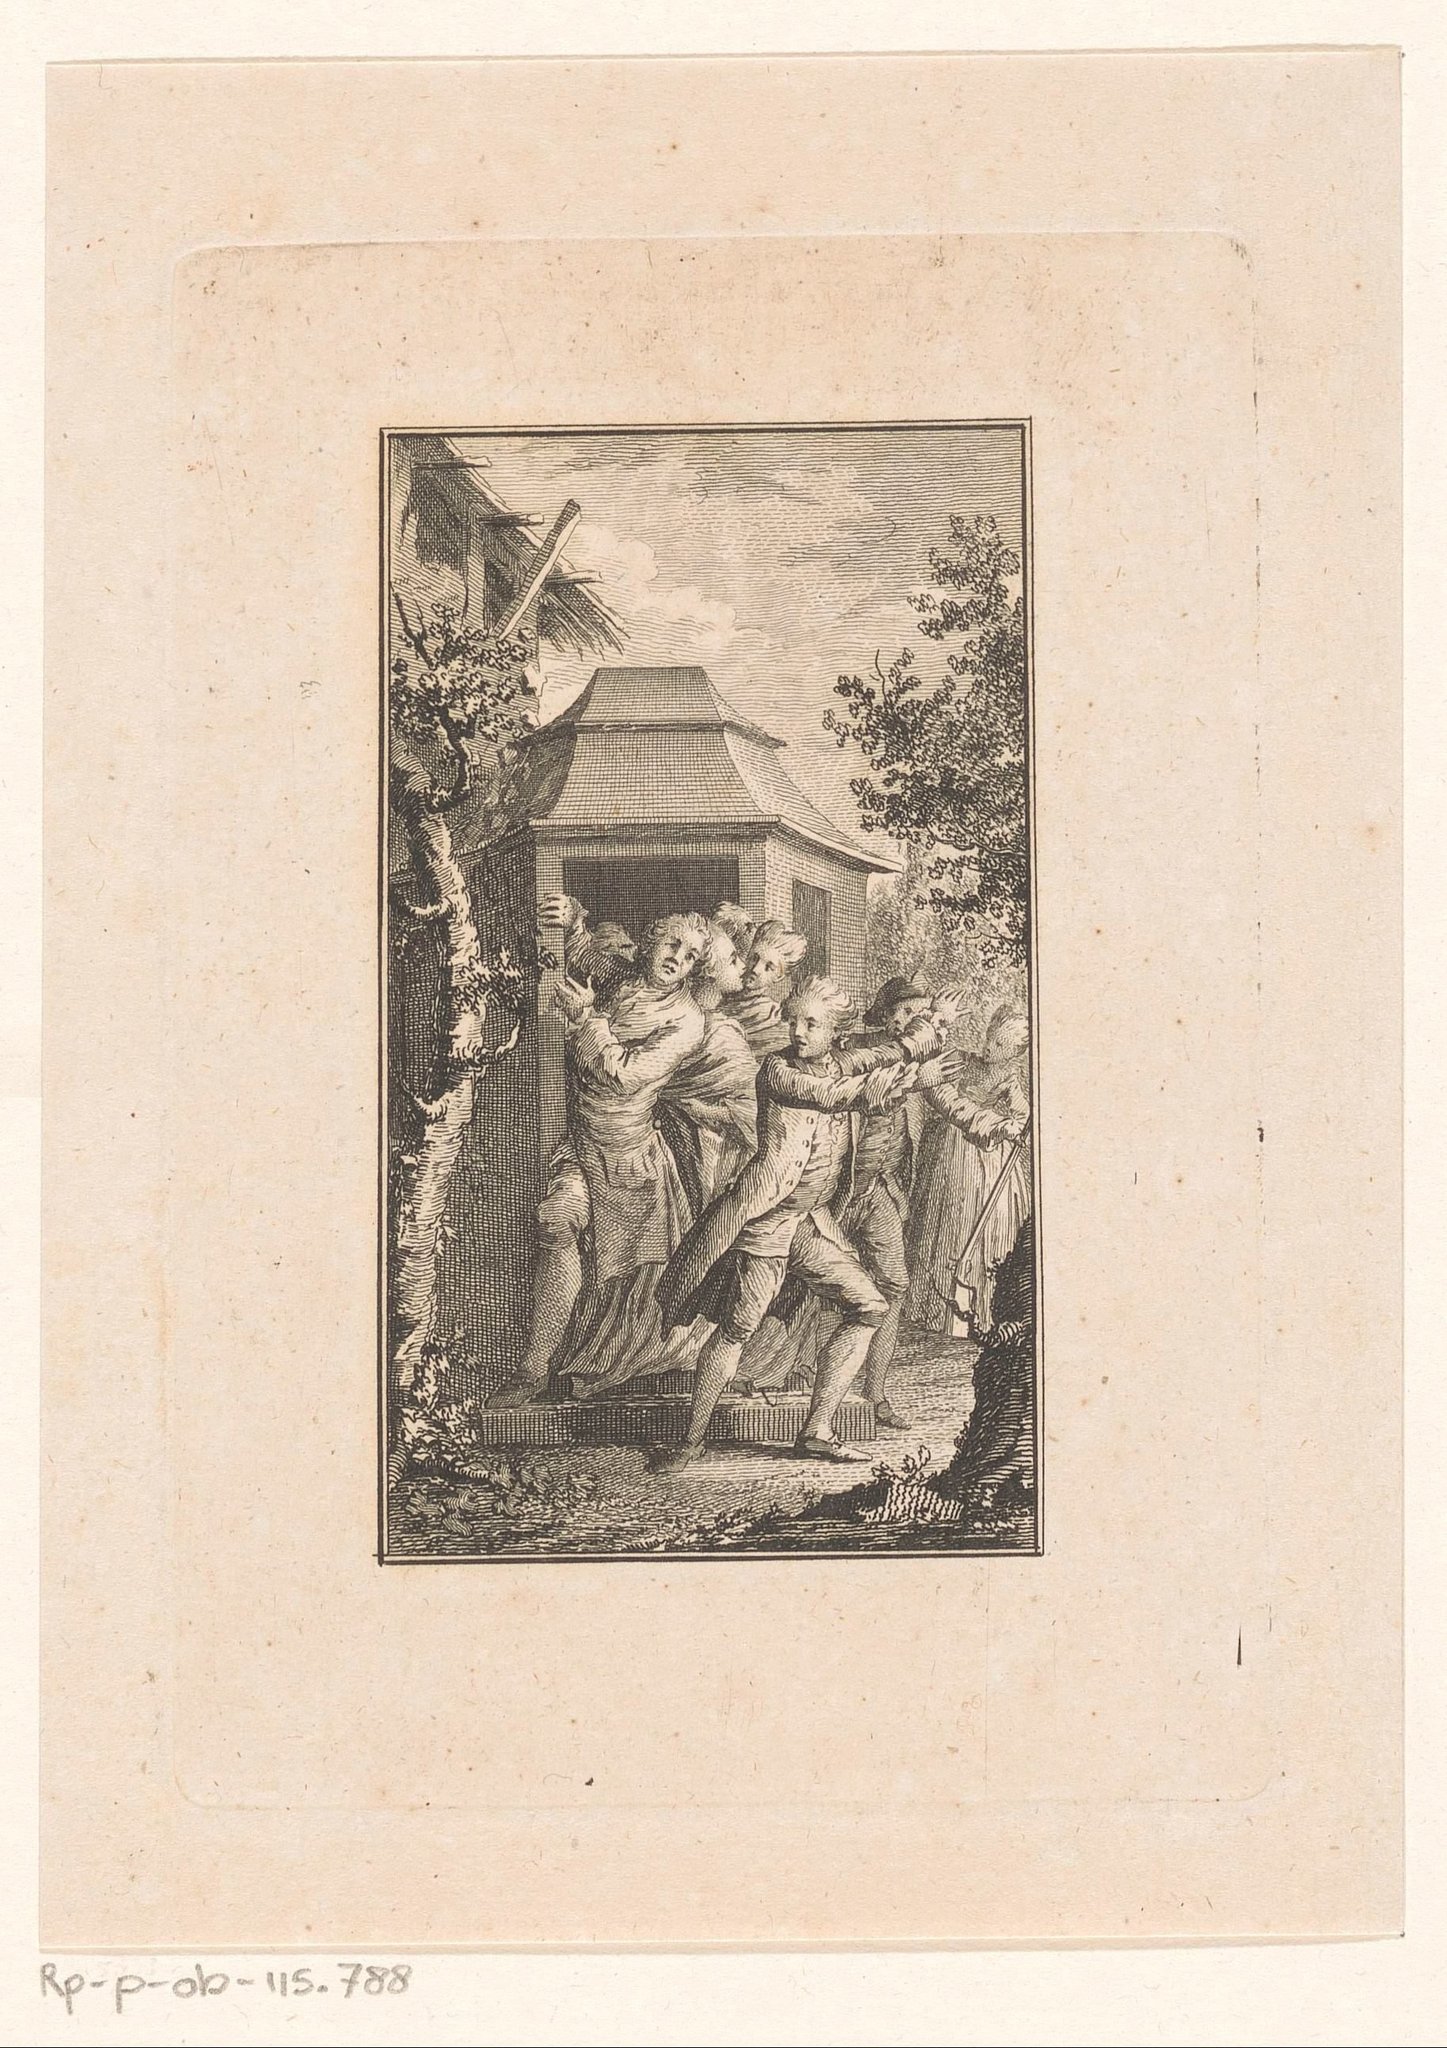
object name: print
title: Mannen en vrouwen vluchten door een deuropening naar buiten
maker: carl leberecht crusius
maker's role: print maker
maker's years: 1740-1779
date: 1750-1779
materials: paper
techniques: etching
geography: leipzig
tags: flight, running away; pursuing